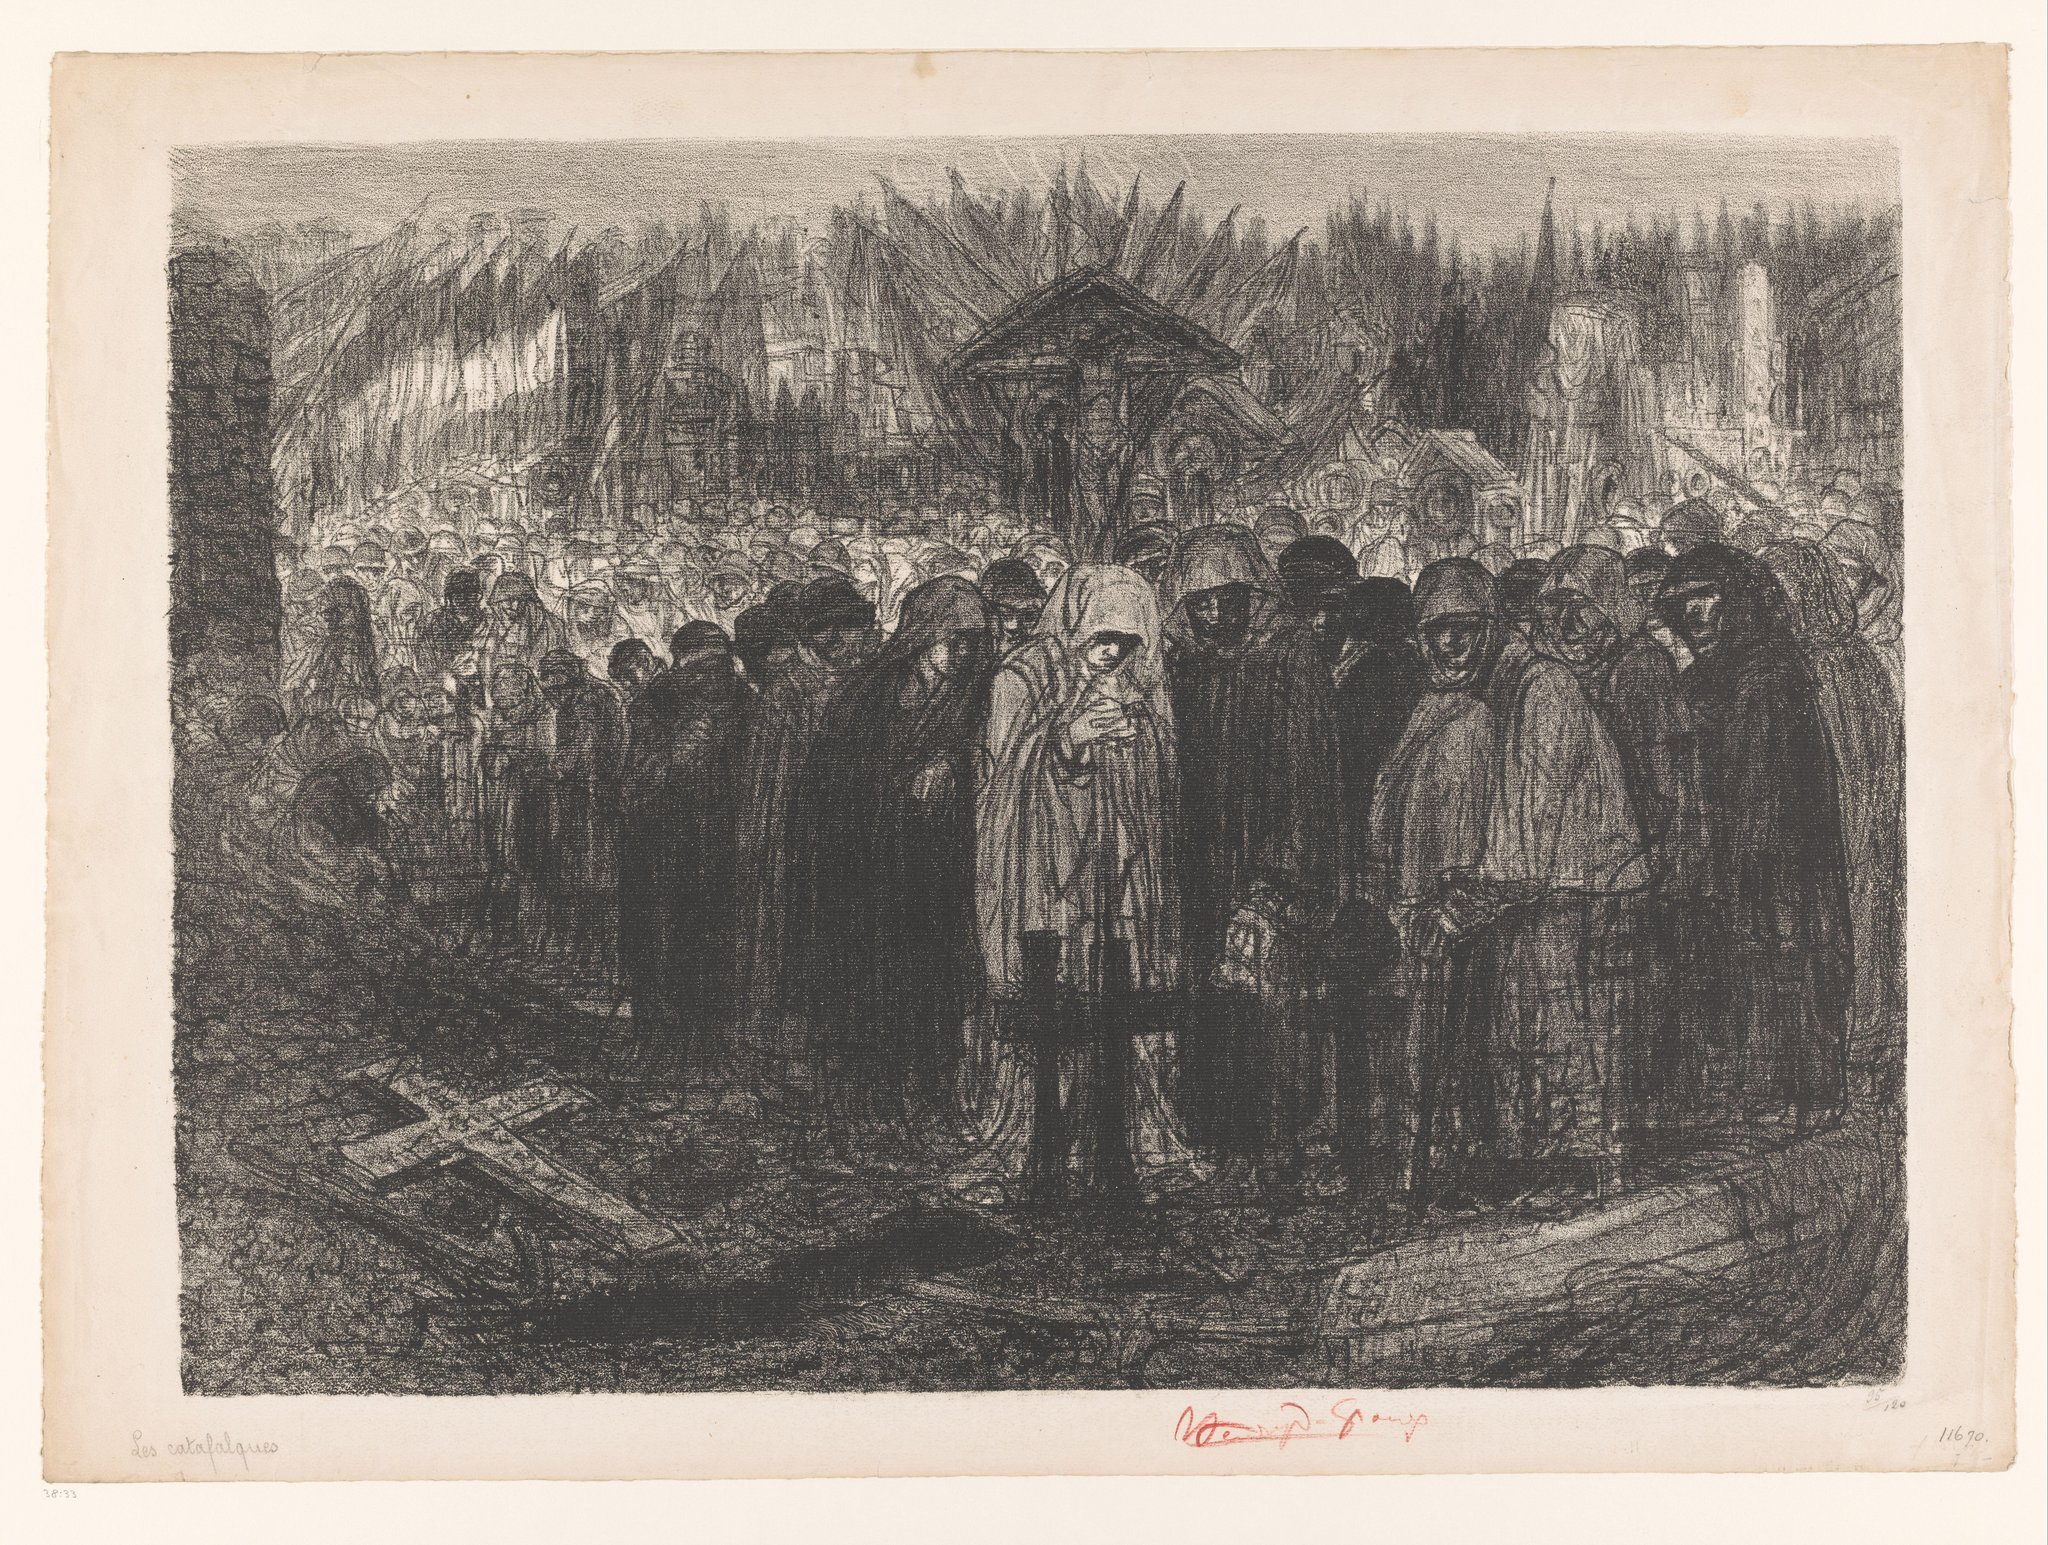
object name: print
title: Grote menigte figuren met kap op een begraafplaats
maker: henri de groux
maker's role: painter, print maker, sculptor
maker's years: 1866-1930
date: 1877-1930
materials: paper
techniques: lithograph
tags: crowd, mob, head-gear: hood, churchyard, cemetery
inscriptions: inscription: ‘les catafalques; 11670’, collector's mark: Lugt 2228, collector's mark: Lugt 2760